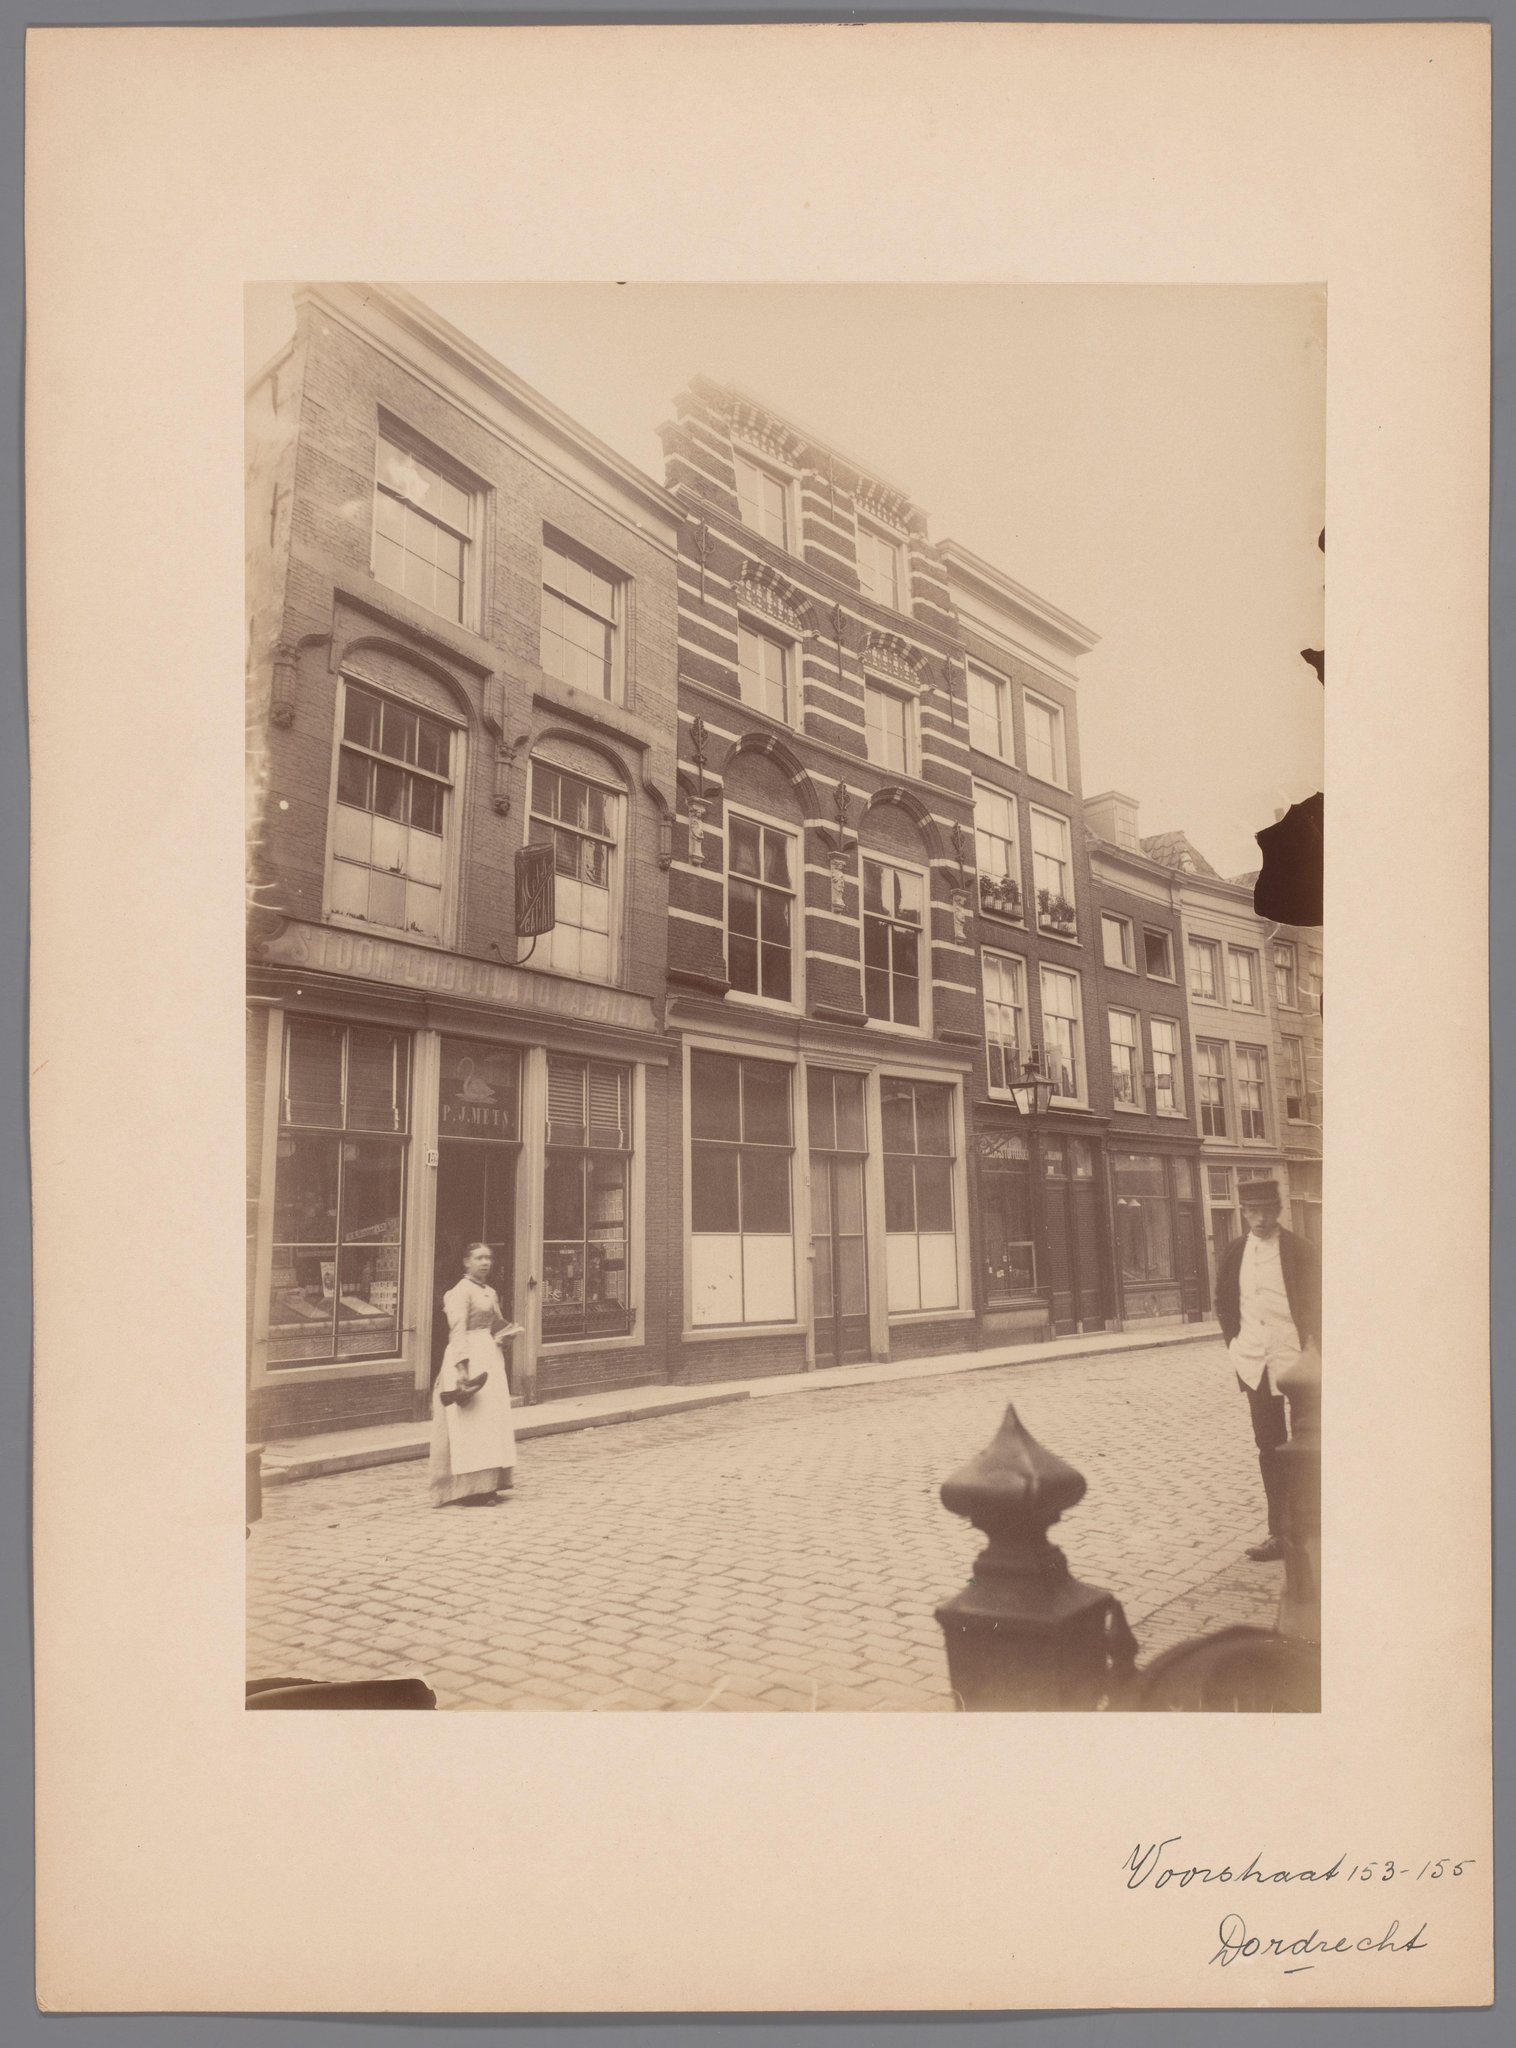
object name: photograph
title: Panden op de Voorstraat 153-155 te Dordrecht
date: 1880-1910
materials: cardboard, photographic support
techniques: albumen print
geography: dordrecht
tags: shop, store, urban housing, façade (of house or building)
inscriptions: annotation: ‘Voorstraat 153-155/ Dordrecht’, annotation: ‘Dordrecht/ Voorstraat N: 153-155’